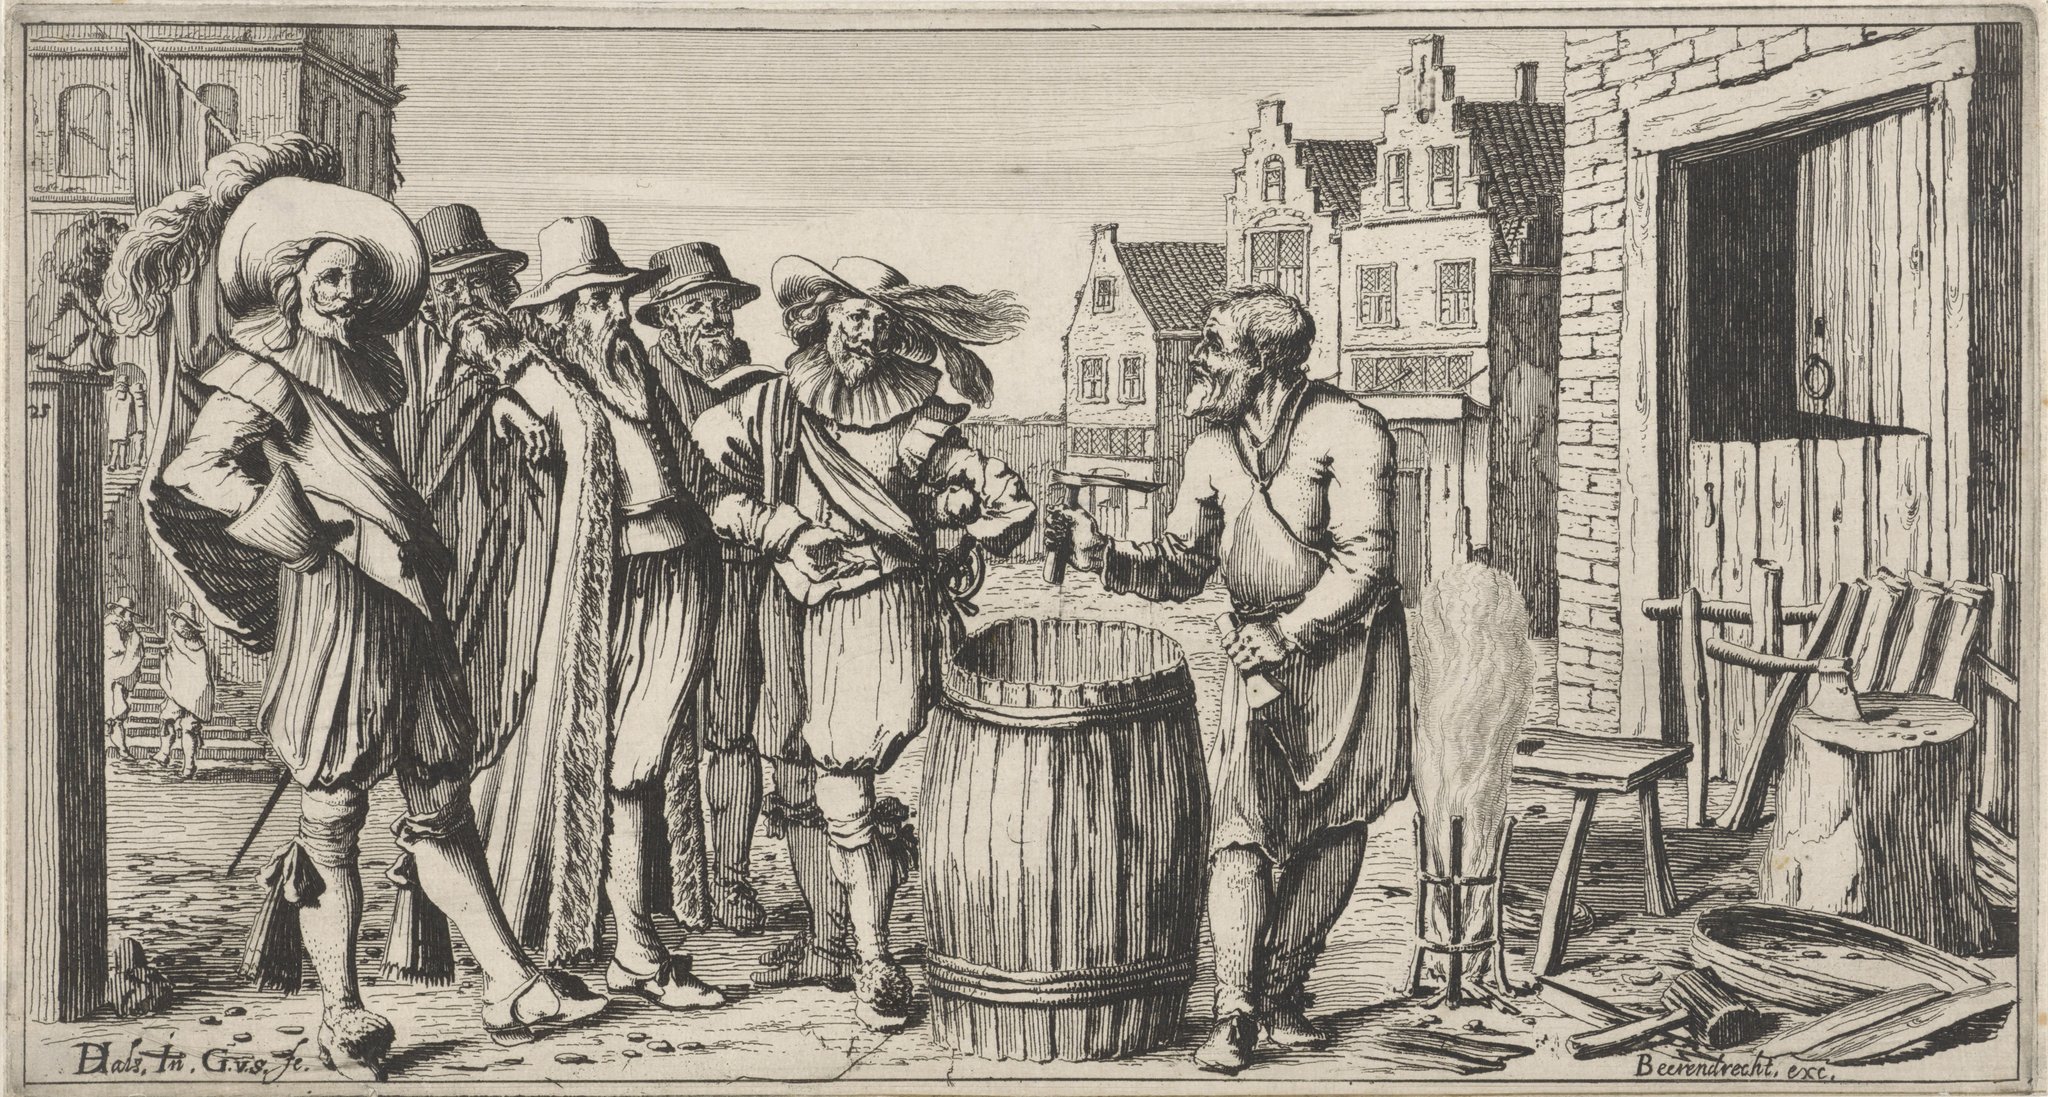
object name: print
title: Kuiper voor zijn werkplaats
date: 1618-1645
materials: paper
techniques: etching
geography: haarlem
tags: handicrafts, craftsman at work, wooden container: barrel, cask, bucket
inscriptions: collector's mark: Lugt 240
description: Vijf mannen kijken toe hoe een kuiper voor zijn werkplaats een ton maakt. Volgens het gedicht dat mogelijk onderdeel van de prent was, spreekt de tonnenmaker met een edelman, dokter, pastoor, politicus en krijgsman.